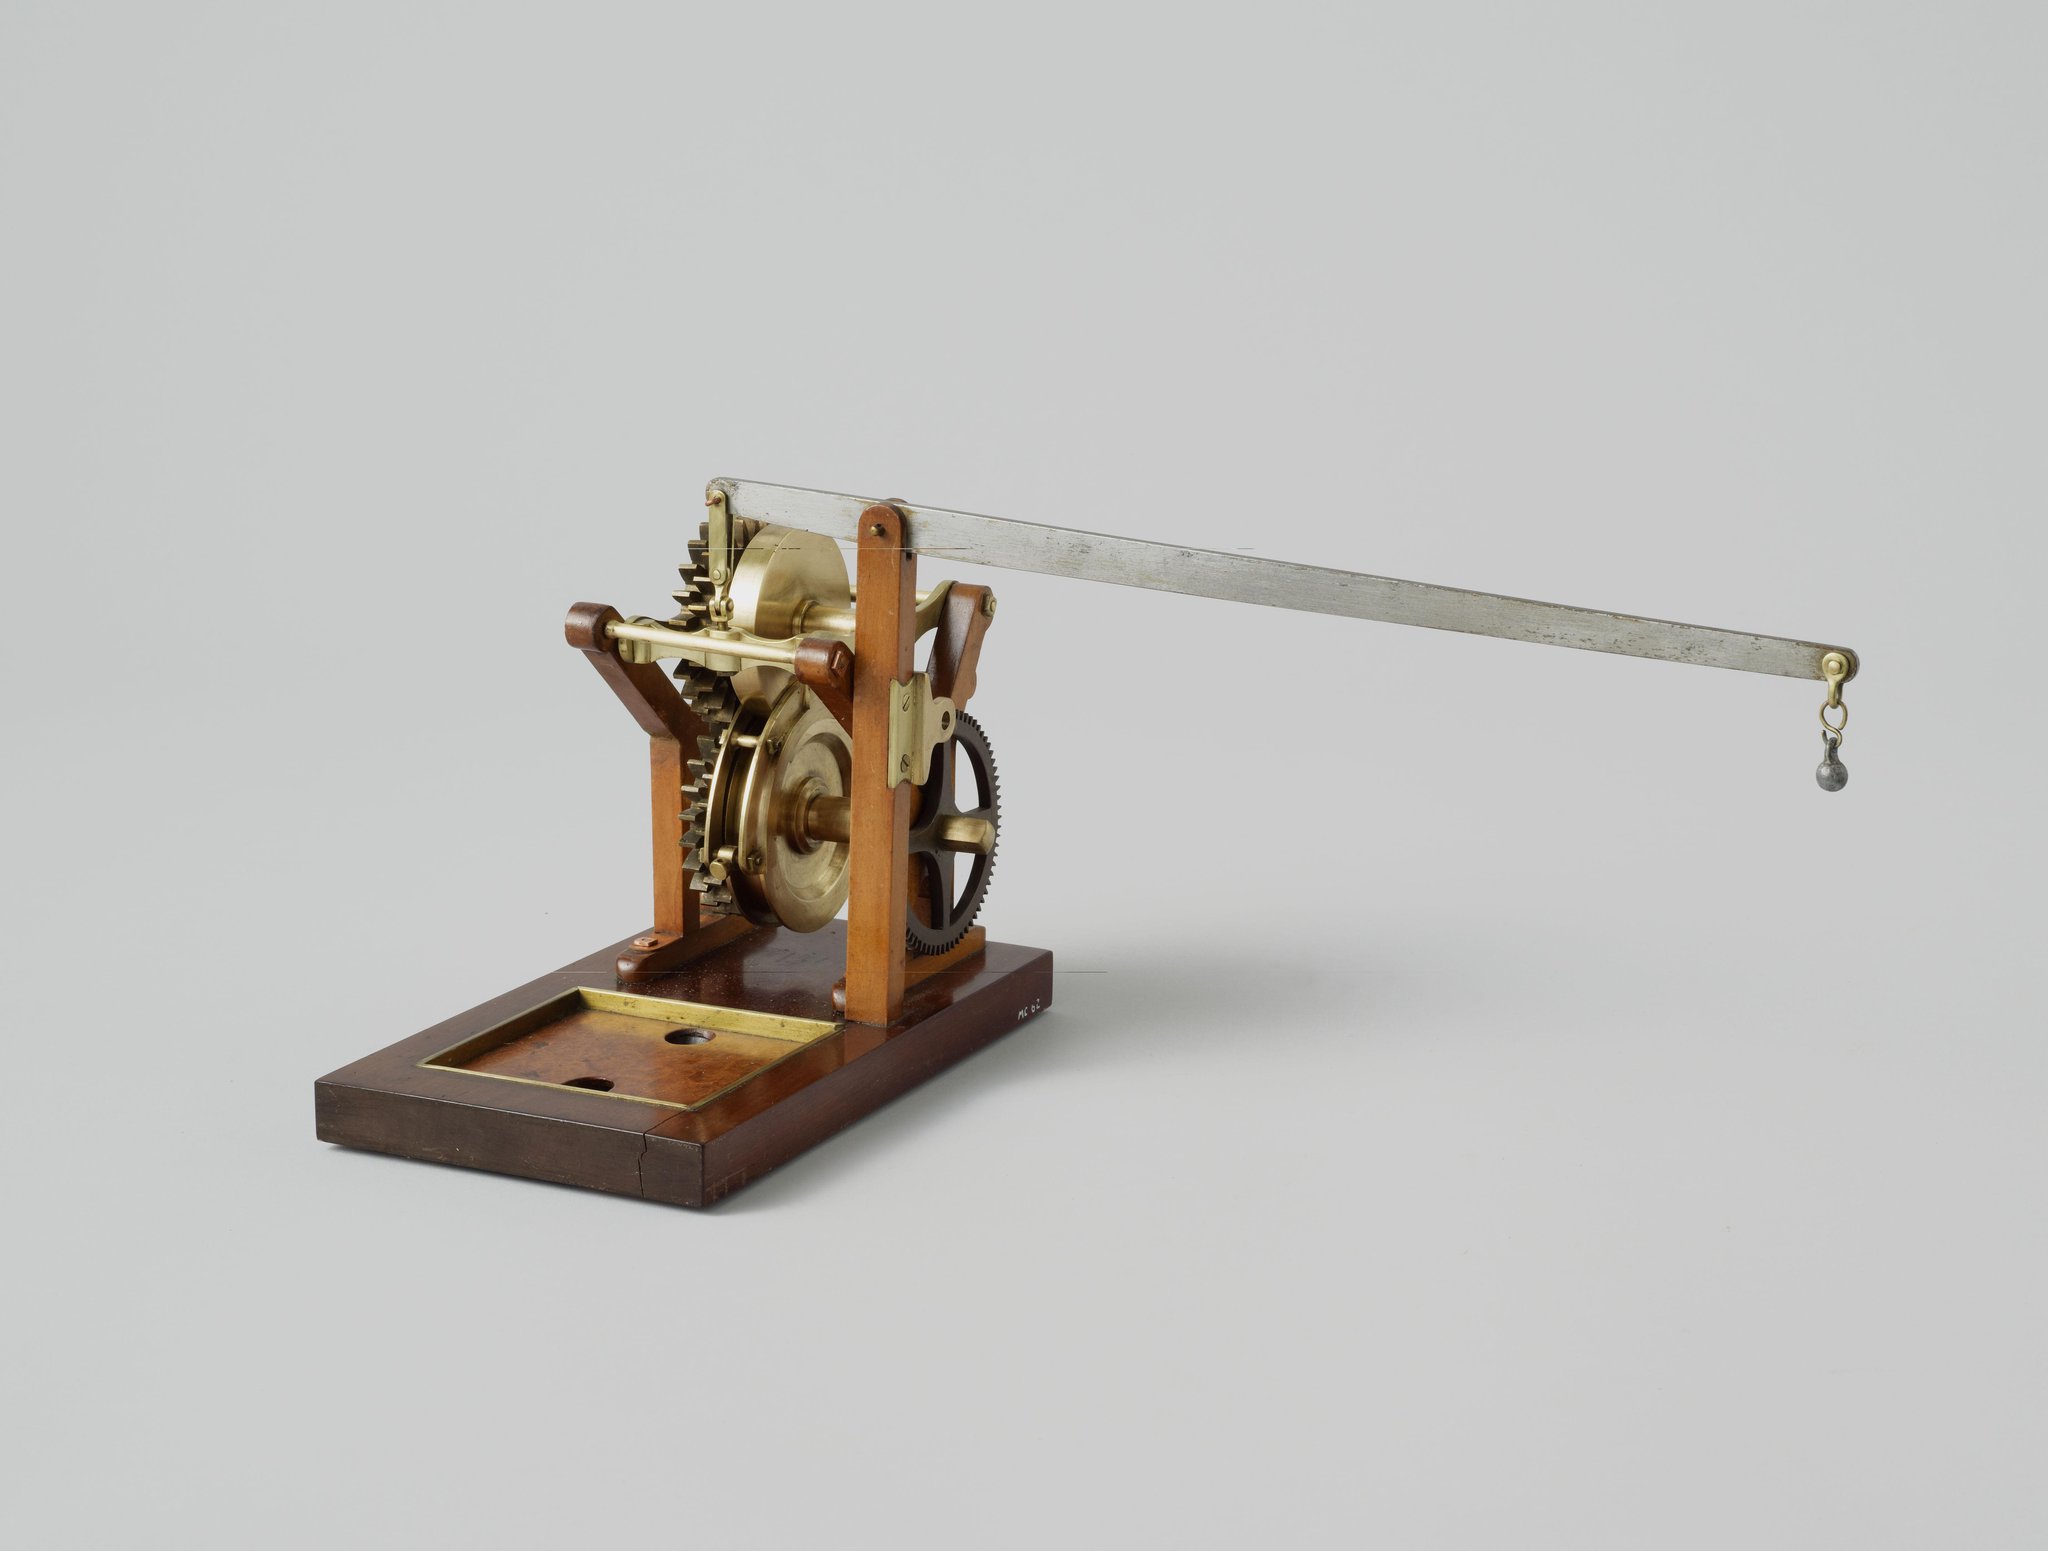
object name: demonstration model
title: Model of an Installation for Tarring Rope Yarn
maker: Anonymous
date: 1800-1825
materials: brass, iron, wood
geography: united states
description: Model van een toestel voor het teren van kabelgarens op grondplank. De werking van het model blijft onduidelijk. Aan een kant wordt een teer-reservoir gesuggereerd met twee gaten waardoor een touw kan lopen. Op de ander helft is een raamwerk met raderwerk opgericht: het ziet eruit als een pers, maar dit blijft onzeker. Twee zware wielen draaien op elkaar: het platte oppervlak van de bovenste draait in de gleuf van de onderste. Een stel wangen dat de omtrek van het onderste wiel volgt ligt hier boven op en geleidt het bovenste wiel. De beweging van beide wielen wordt gesynchroniseerd door een stel dubbele tandwielen naast de wielen. Het bovenste wiel met tandwielen is in een frame gemonteerd dat met behulp van een hefboom met gewicht aan een kant op en neer bewogen kan worden, waarschijnlijk om de druk te regelen. Het onderste wiel wordt aangedreven door een zwengel, die ontbreekt, en heeft aan de zijkant van het frame een tandwiel dat, waarschijnlijk met een pal die nu ontbreekt, teruglopen verhinderde.